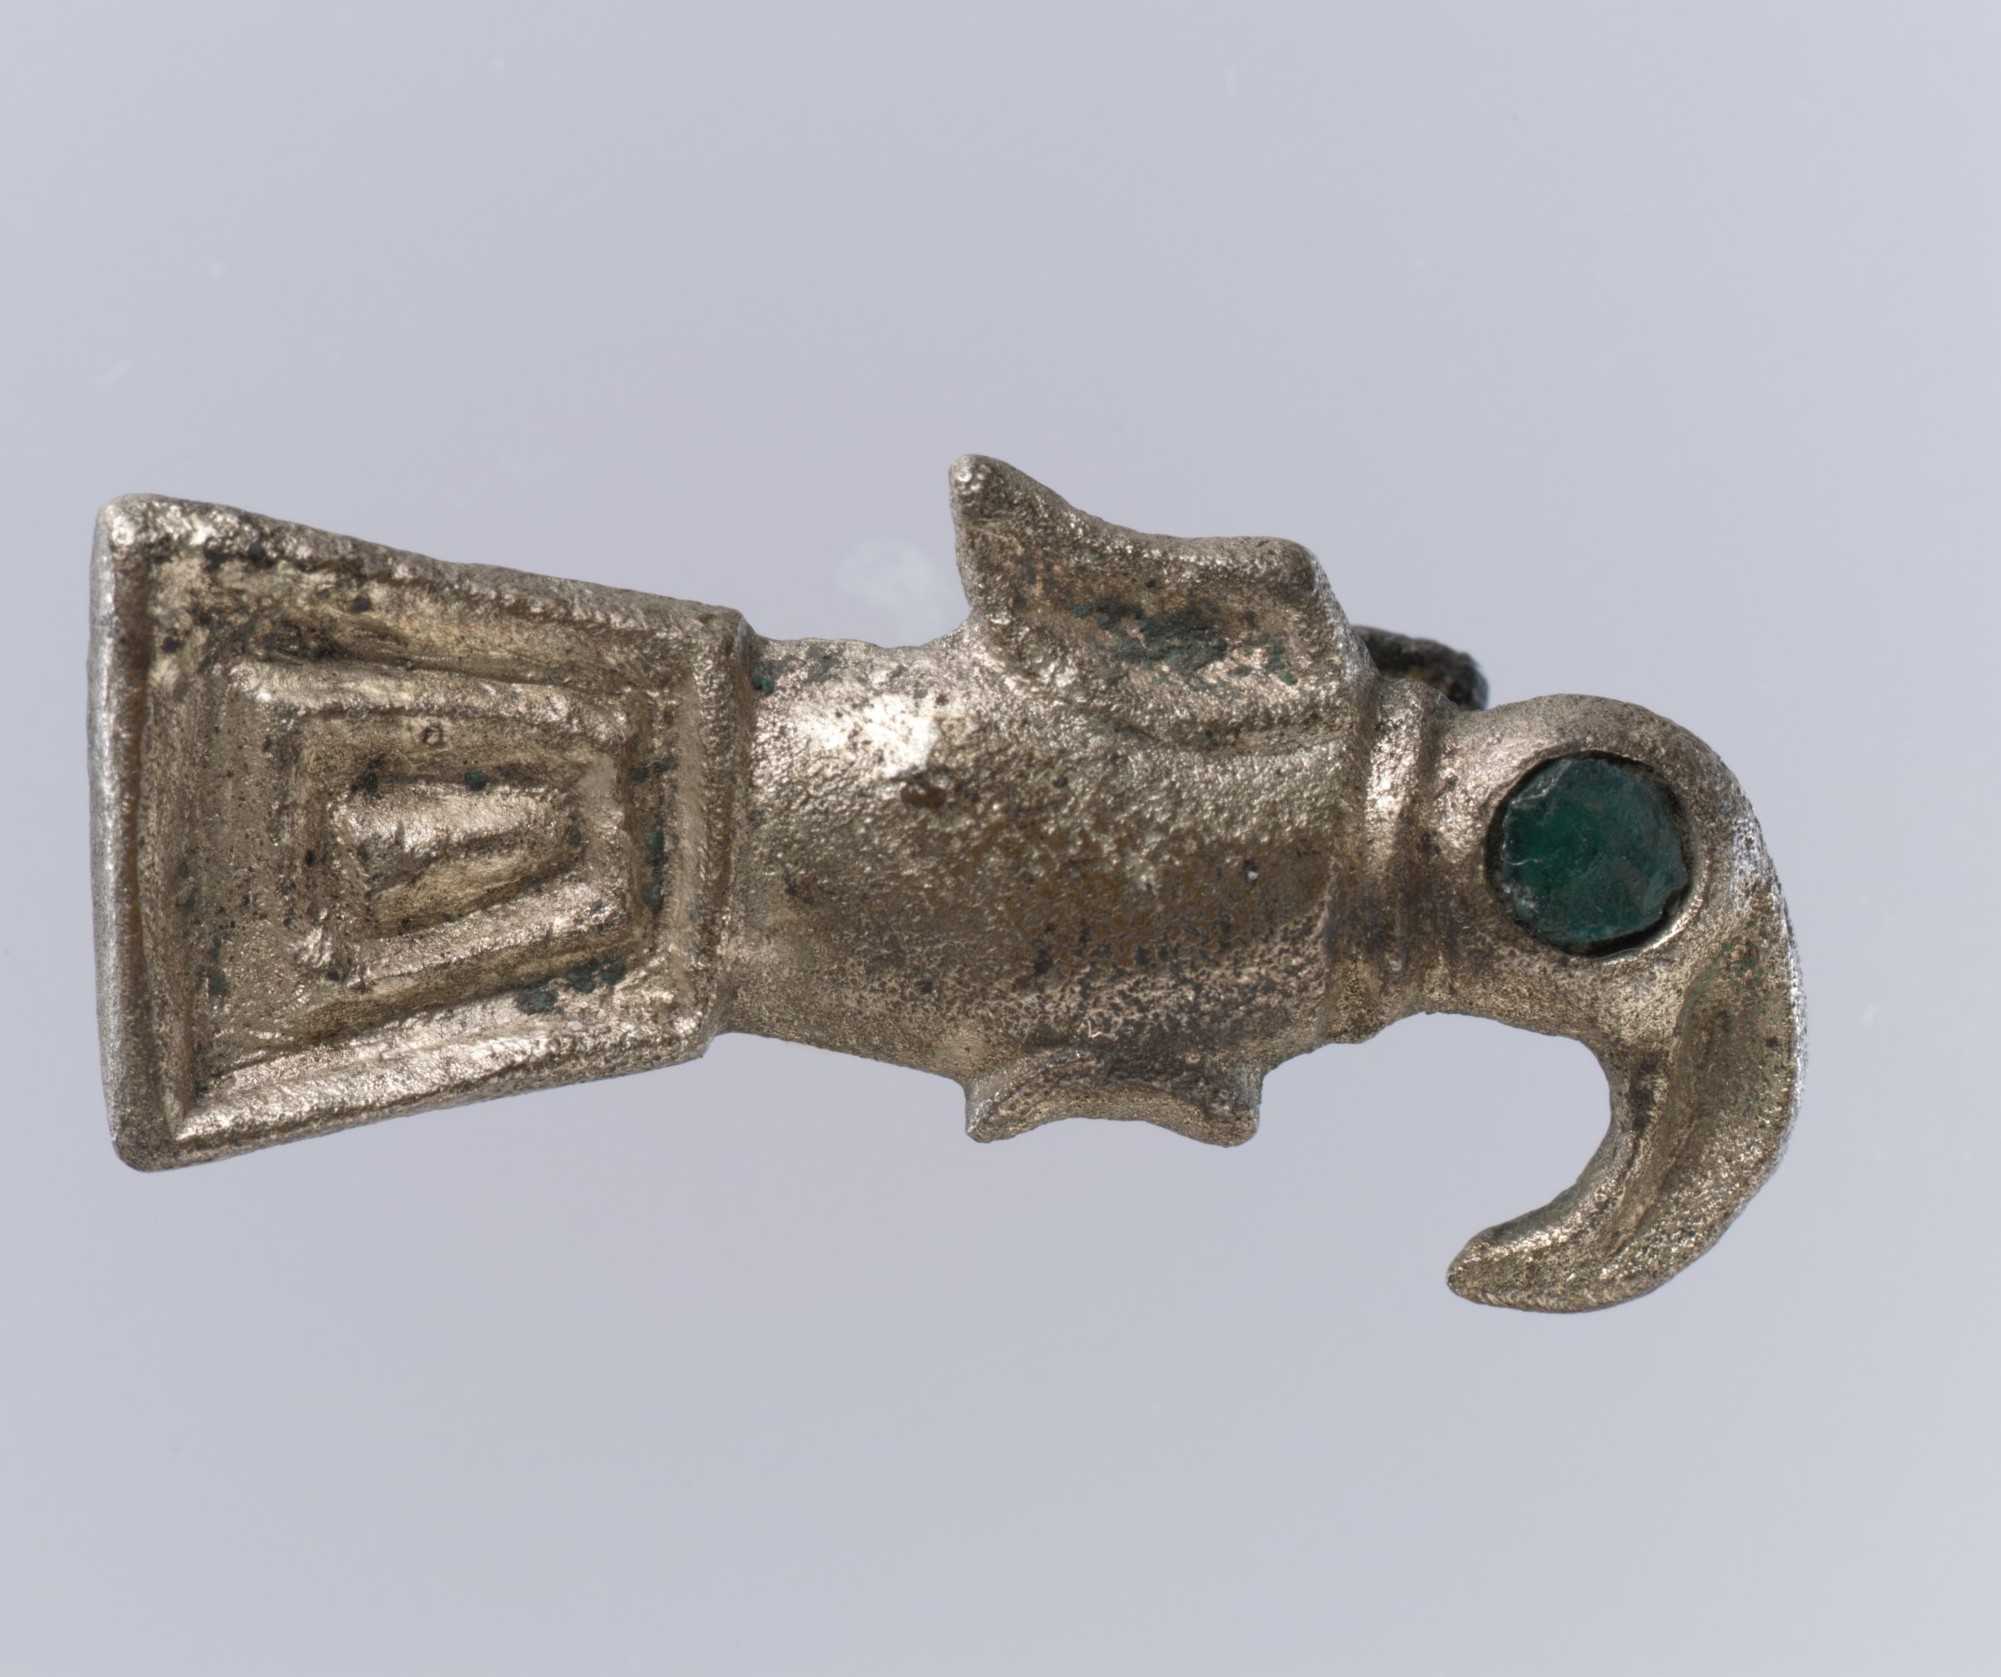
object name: brooch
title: Bird-Shaped Brooch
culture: frankish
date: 551-600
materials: glass, paste, silver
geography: northern france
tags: birds